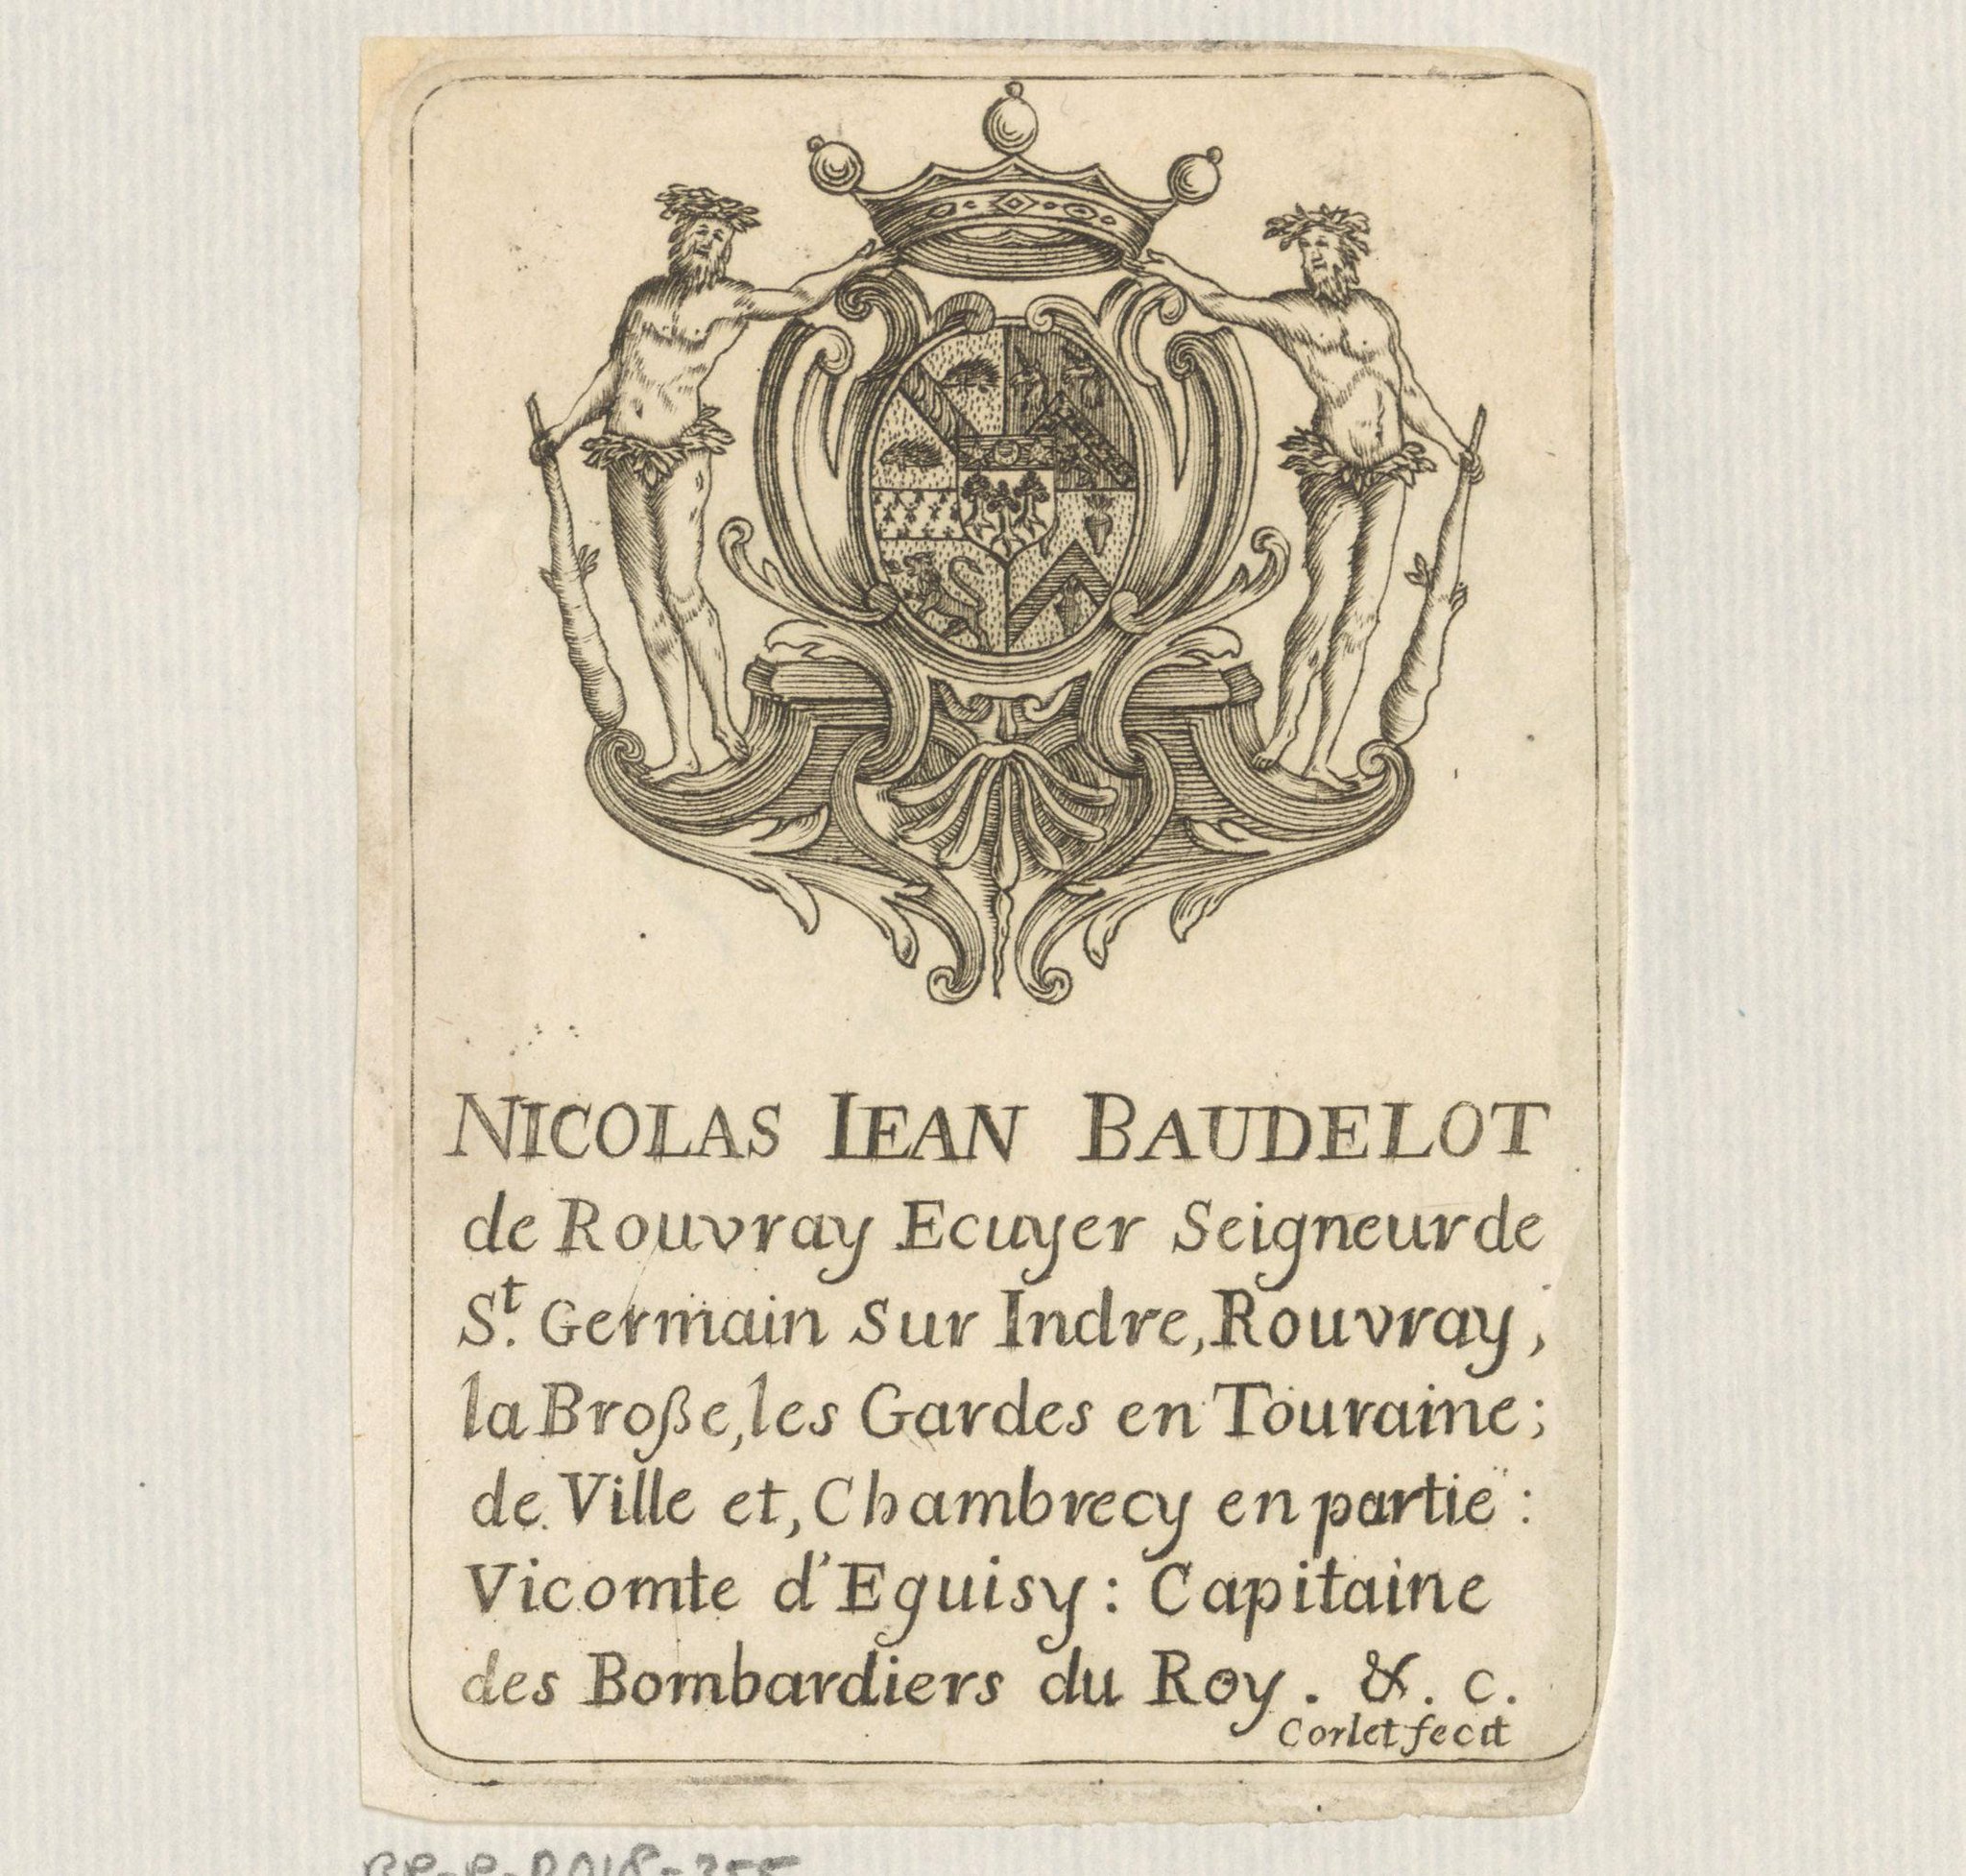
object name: bookplate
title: Nicolas Iean Baudelot de Rouvray ecuyer seigneur de (...)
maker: Anonymous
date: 1600-1749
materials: paper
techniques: engraving, etching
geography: france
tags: weapons for striking a blow: club, armorial bearing, heraldry, man (showing himself) undressed, quasi-nude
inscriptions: collector's mark: Lugt 344, stamp: ‘Dupl.’